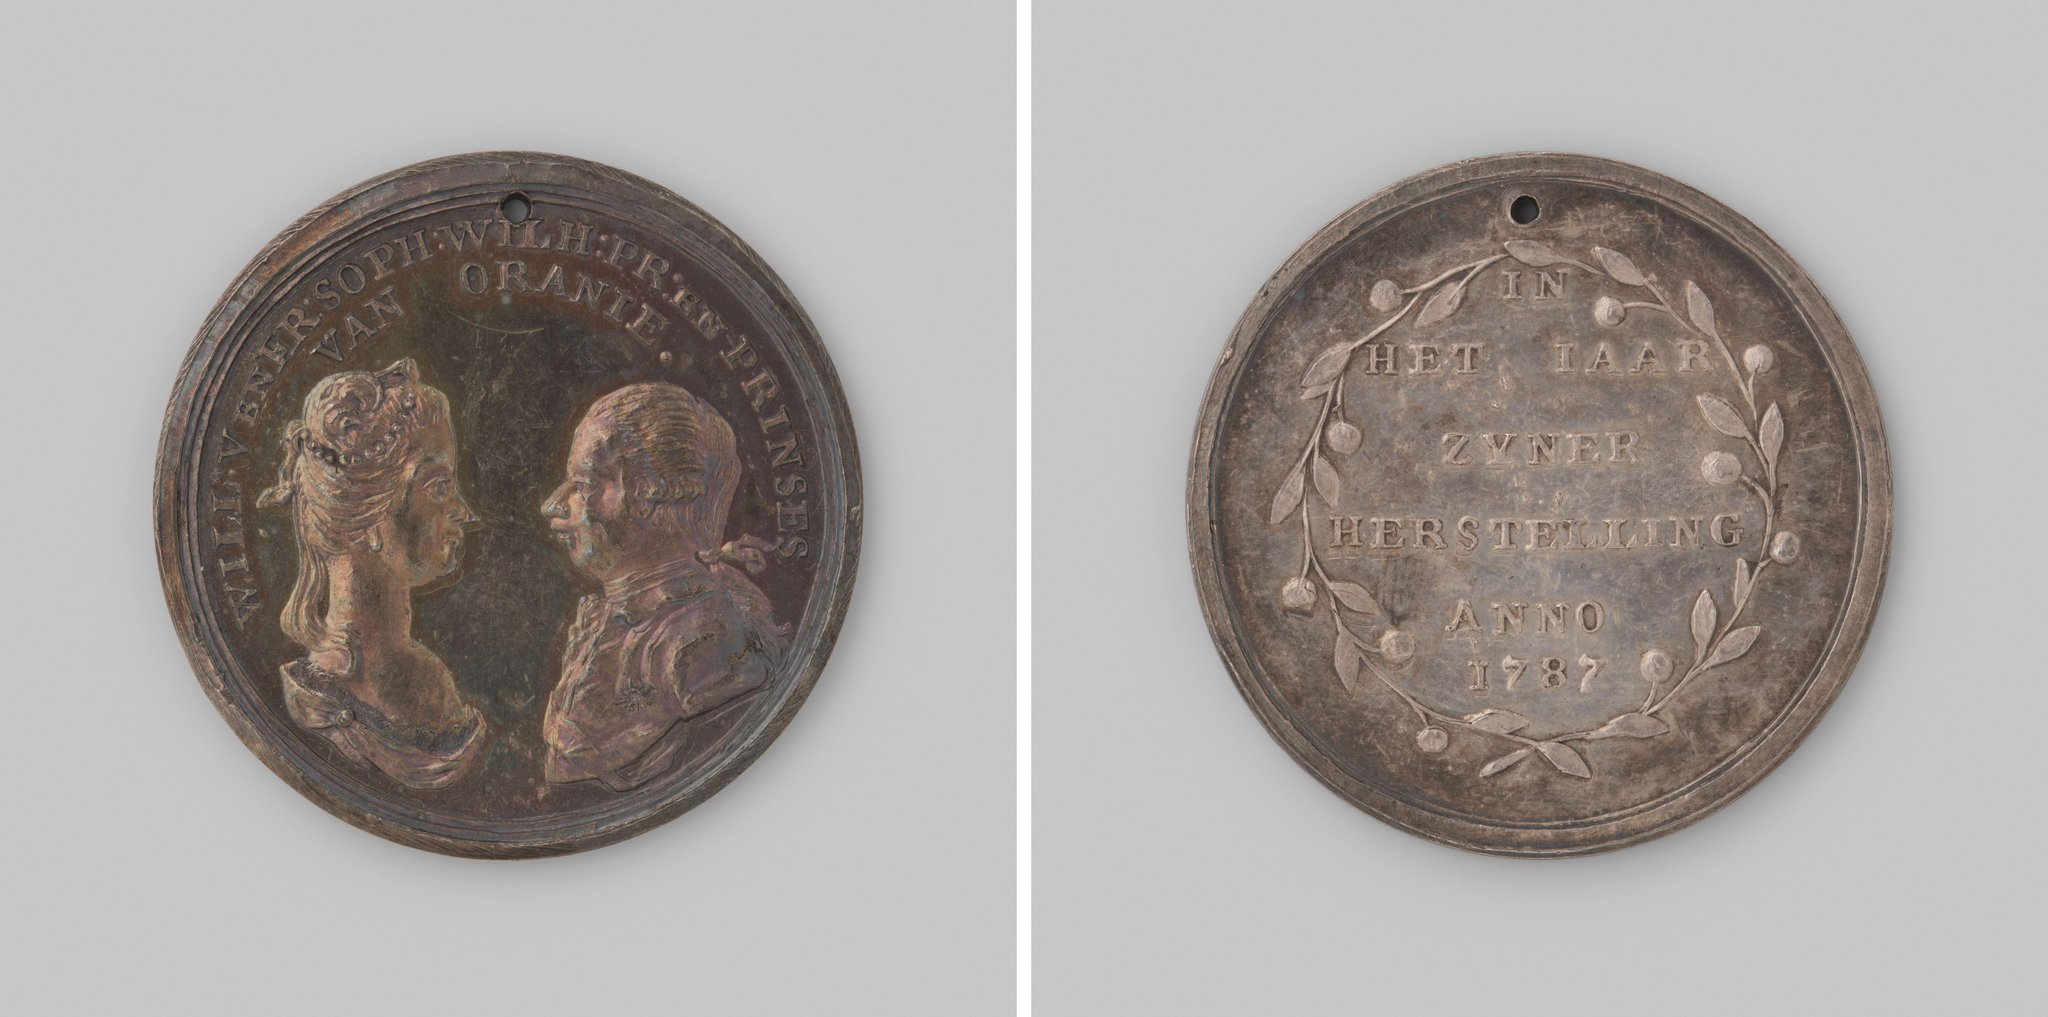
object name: history medal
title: Herstelling van de macht van de erfstadhouder 1787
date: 1787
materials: silver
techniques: pierced, pressing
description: Zilveren penning met kleine doorboring, op de voorzijde de elkaar toegewende borstbeelden van de stadhouder en zijn vrouw, met omschrift', op de keerzijde zes regels tekst binnen een rondlopende oranjetak.